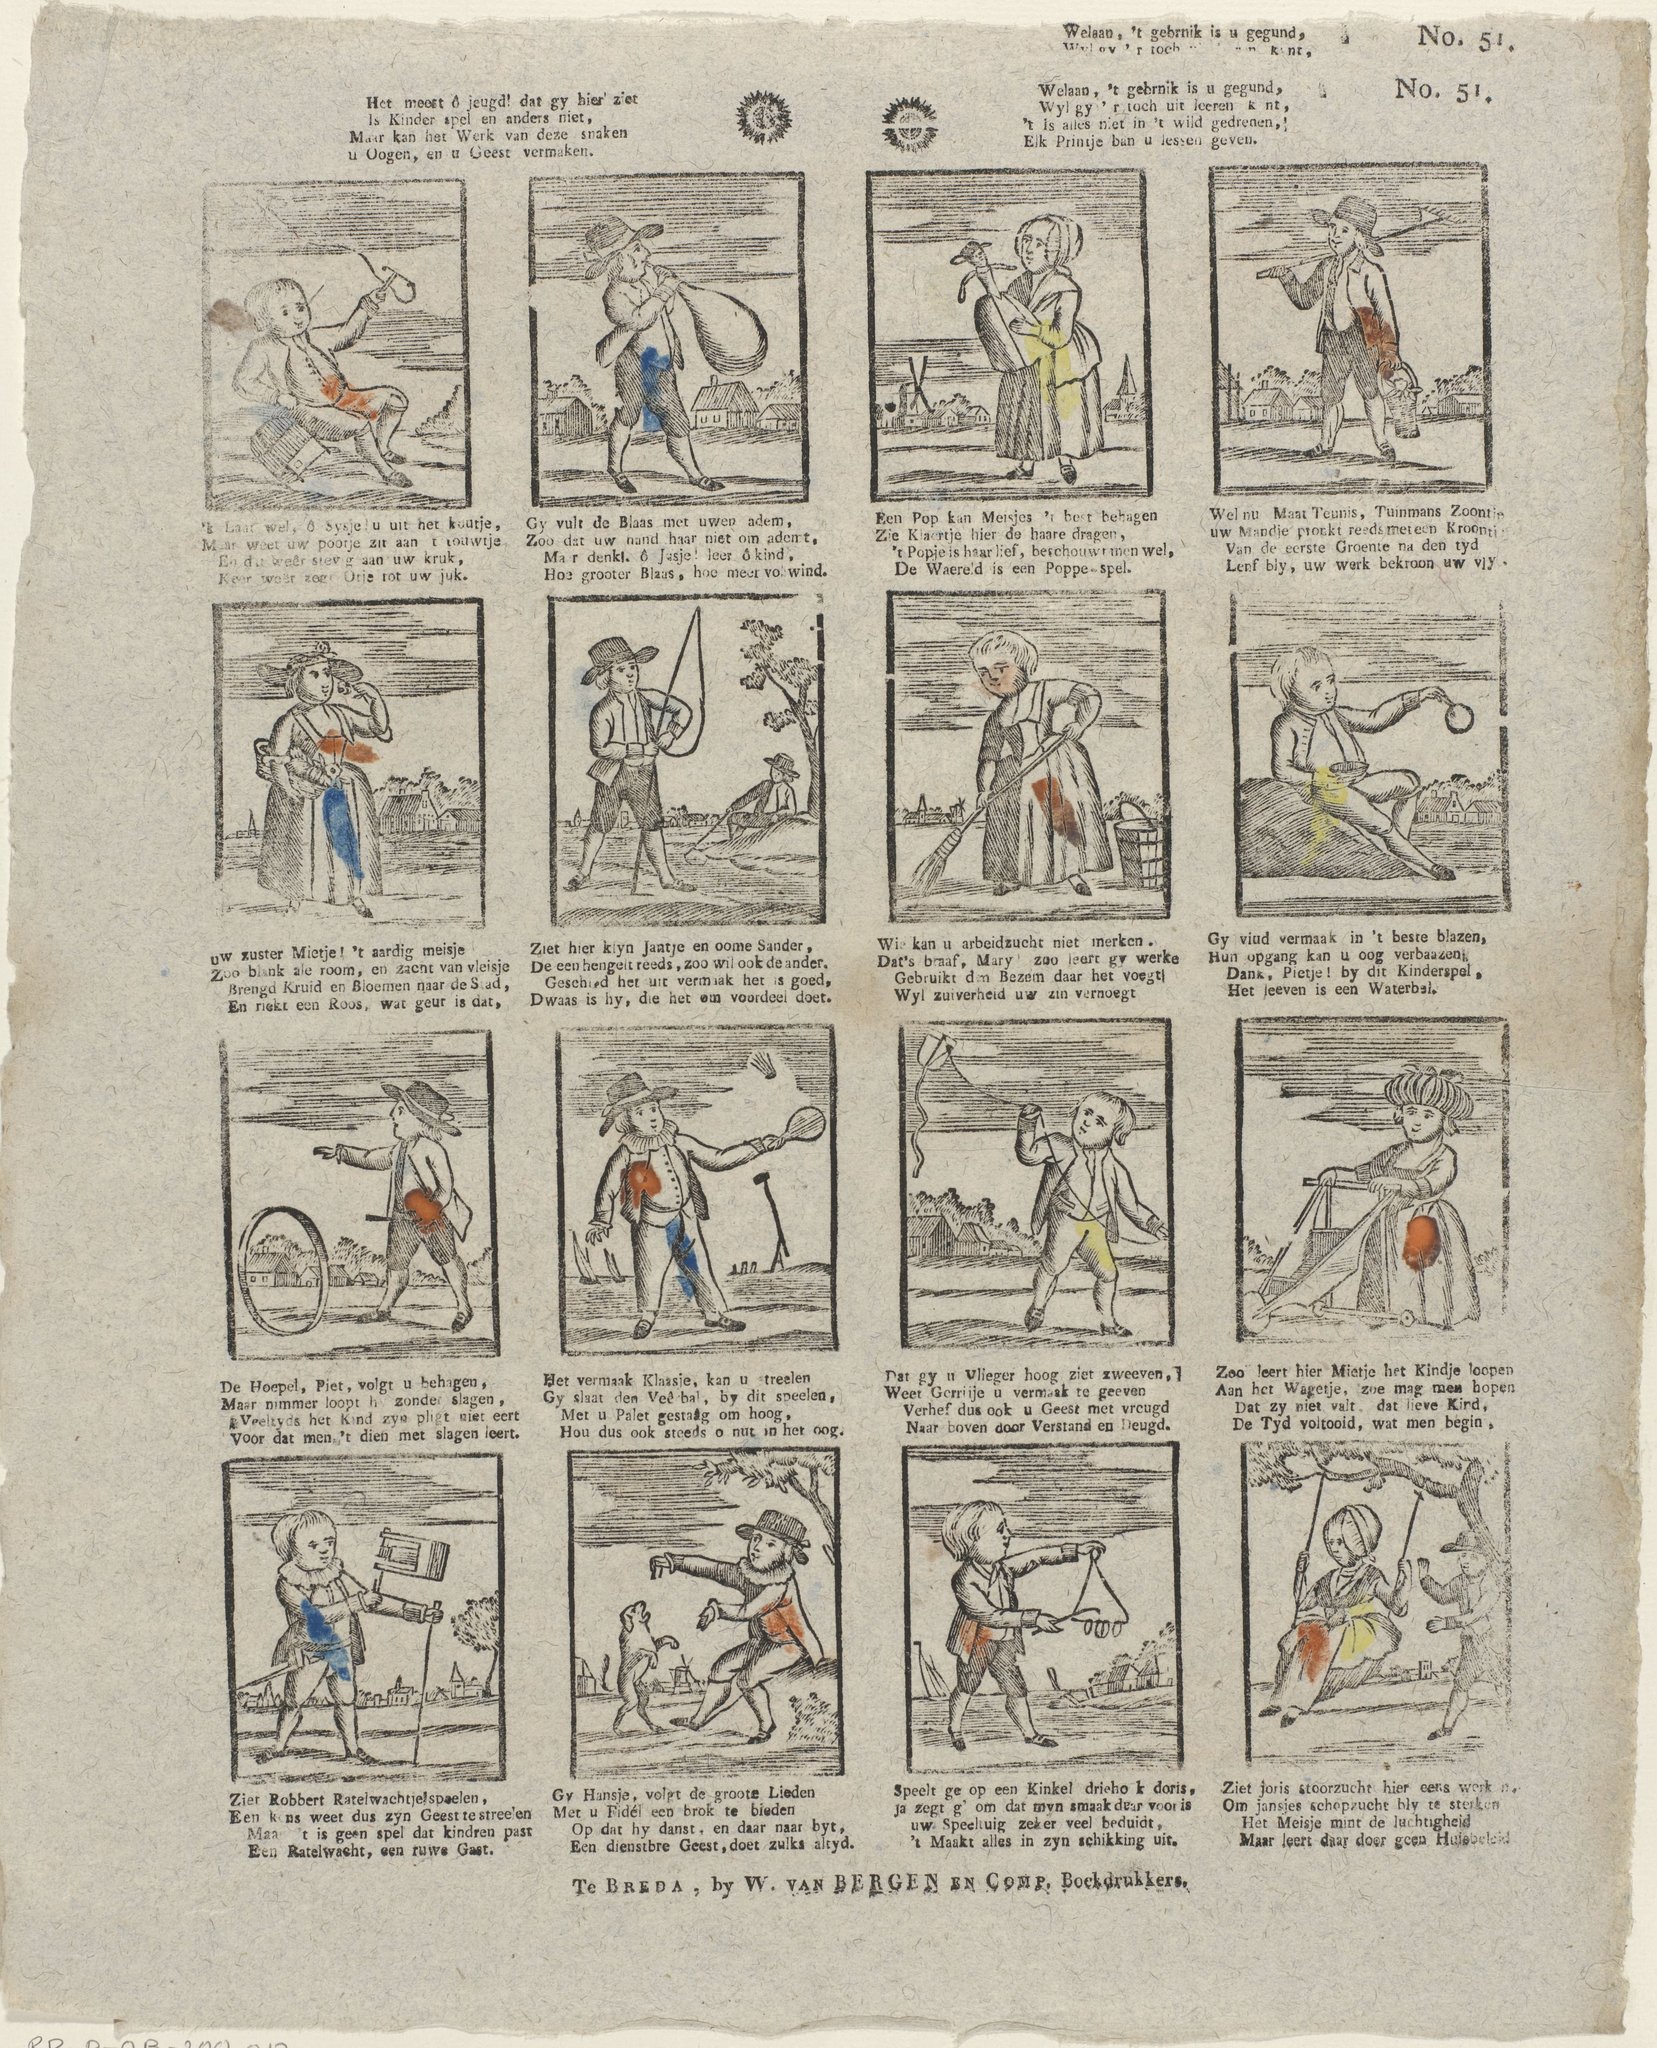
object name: print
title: Het meest ô jeugd! dat gy hier' ziet / Is kinder spel en anders niet (...)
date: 1818-1828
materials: paper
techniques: colour, letterpress printing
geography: breda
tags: children's games and plays, (playing with) toys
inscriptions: collector's mark: Lugt 2760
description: Blad met 16 voorstellingen van verschillende kinderspelen, zoals spelen met poppen, hoepelen en vliegeren. Onder elke afbeelding een vierregelig vers. Genummerd rechtboven: No. 51.